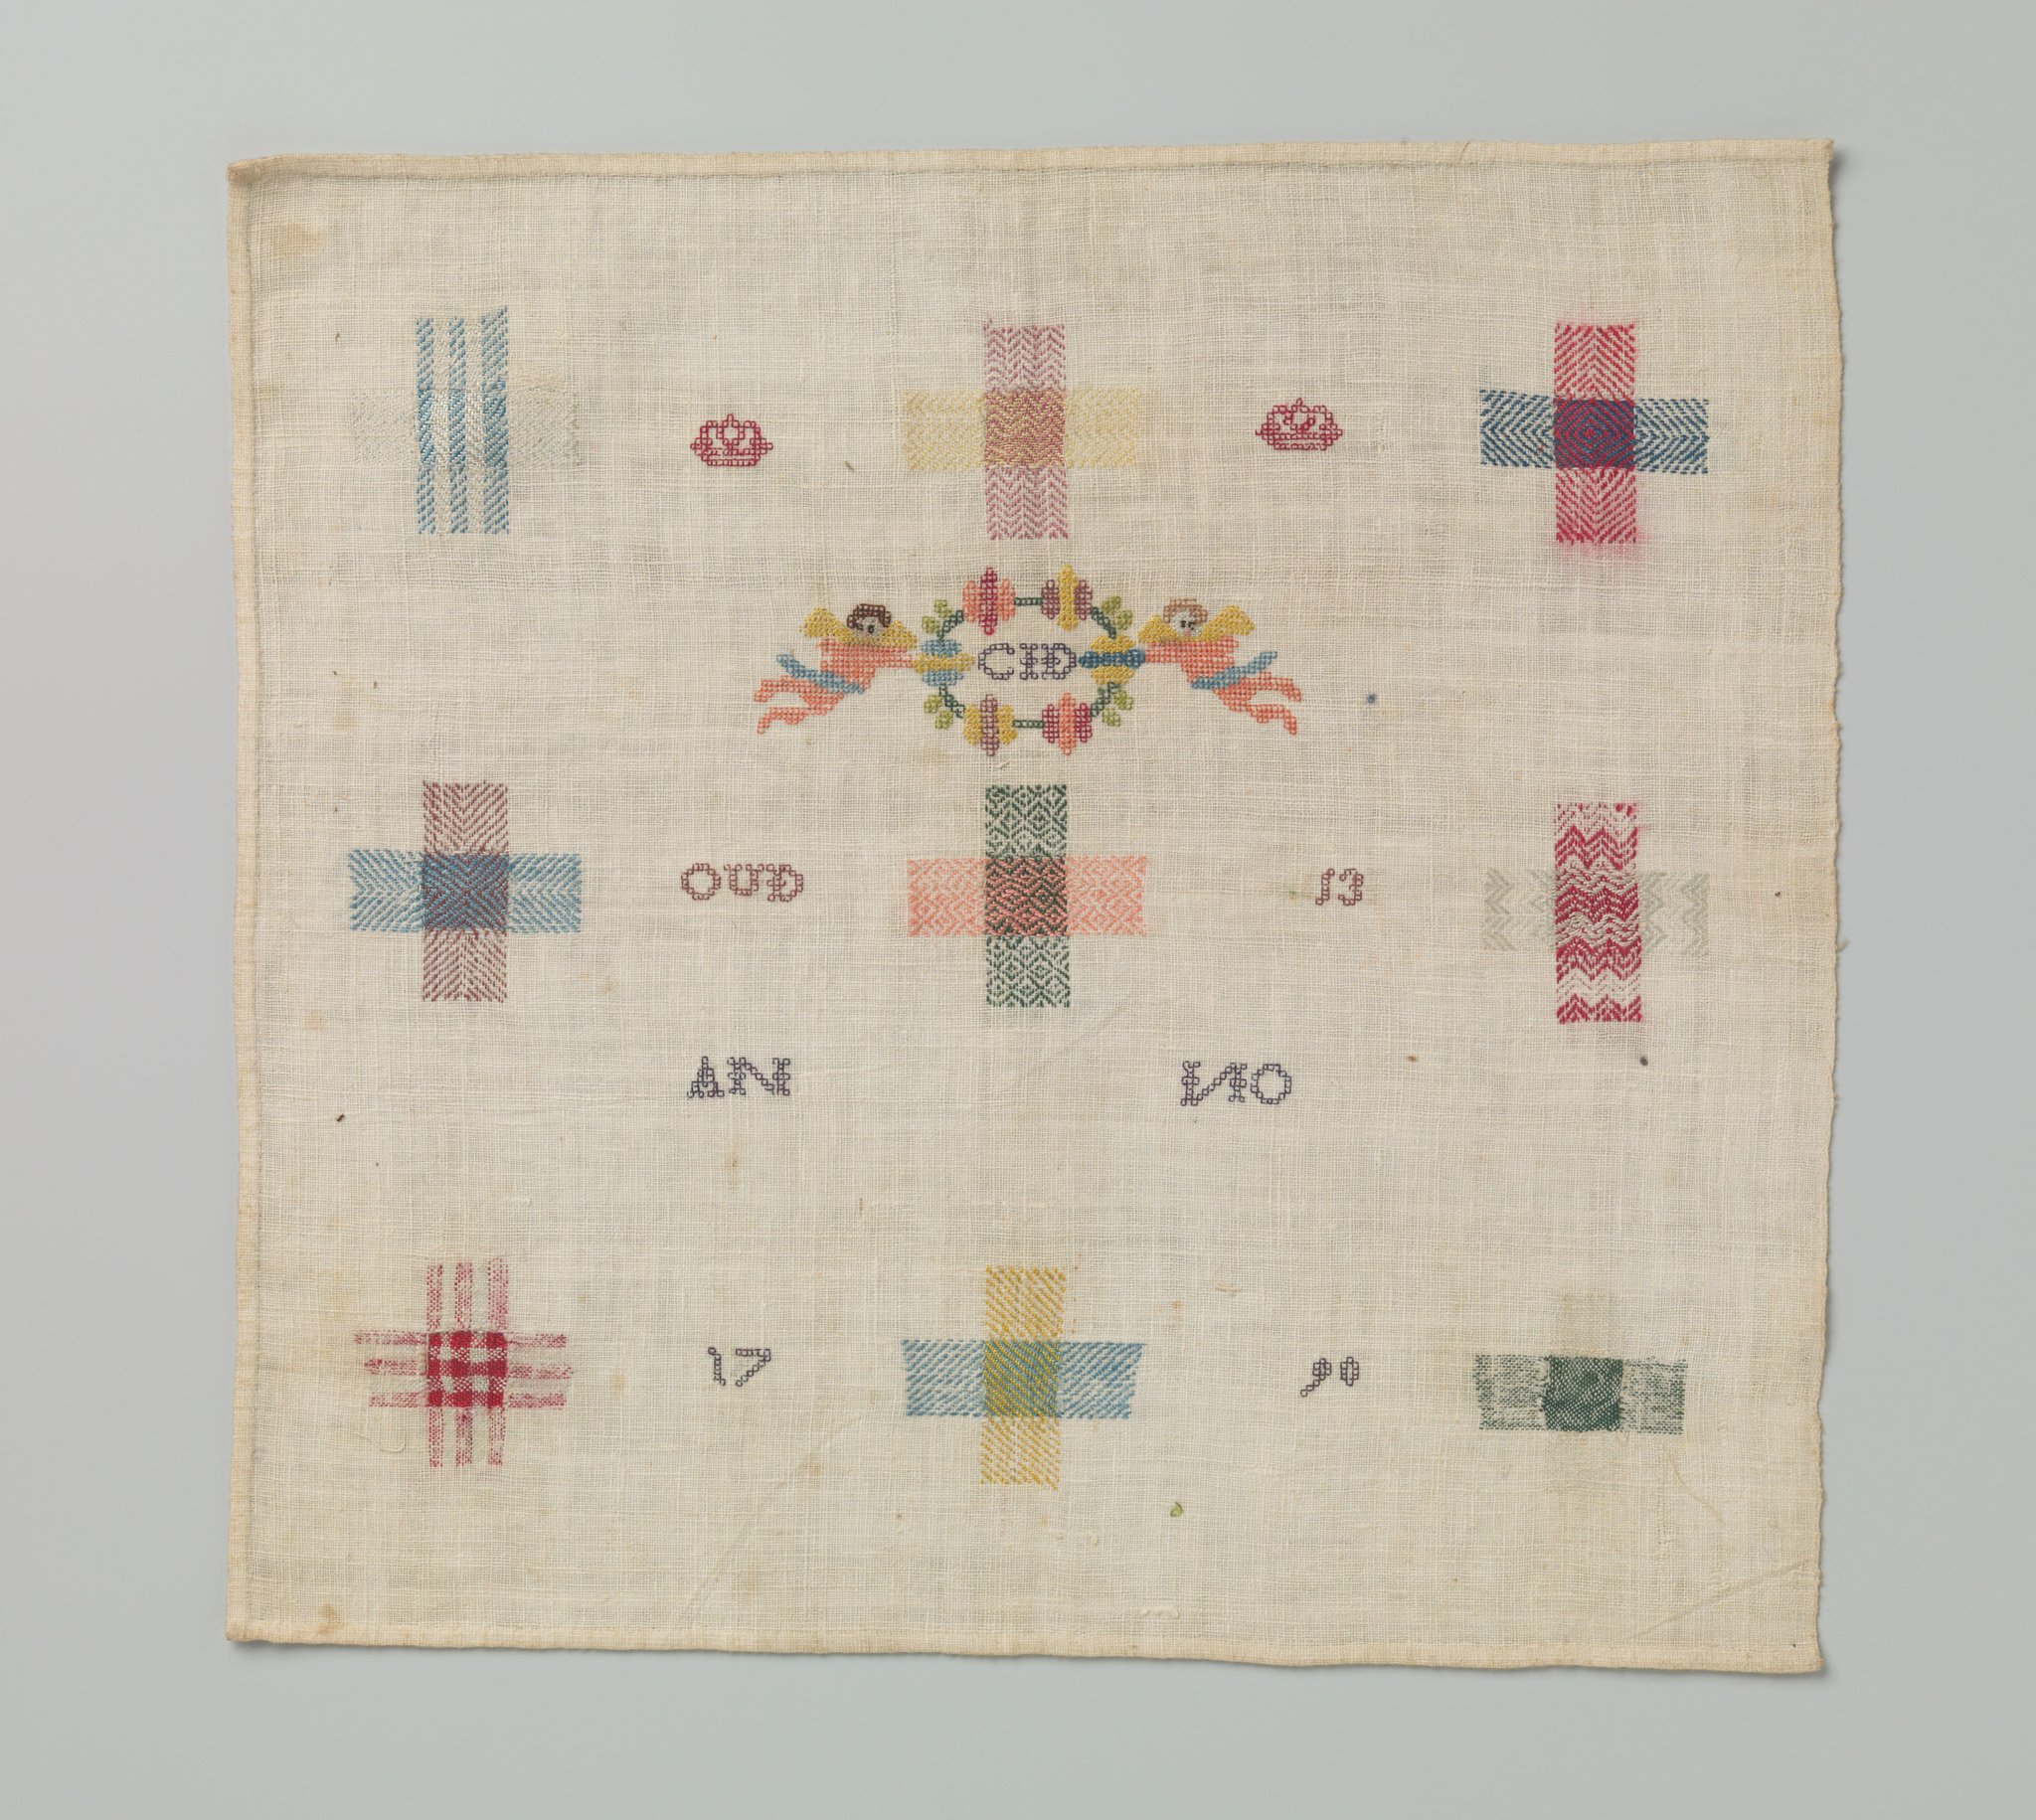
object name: stoplap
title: Stoplap van veelkleurige zijde op katoenen mousseline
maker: Anonymous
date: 1790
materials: cotton, silk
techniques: embroidered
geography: haarlem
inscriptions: date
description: Het borduurwerk heeft de initialen CD in een krans met beschermengelen, de tekst OUD 13, de datering 1790 en bovenaan twee rode kronen.